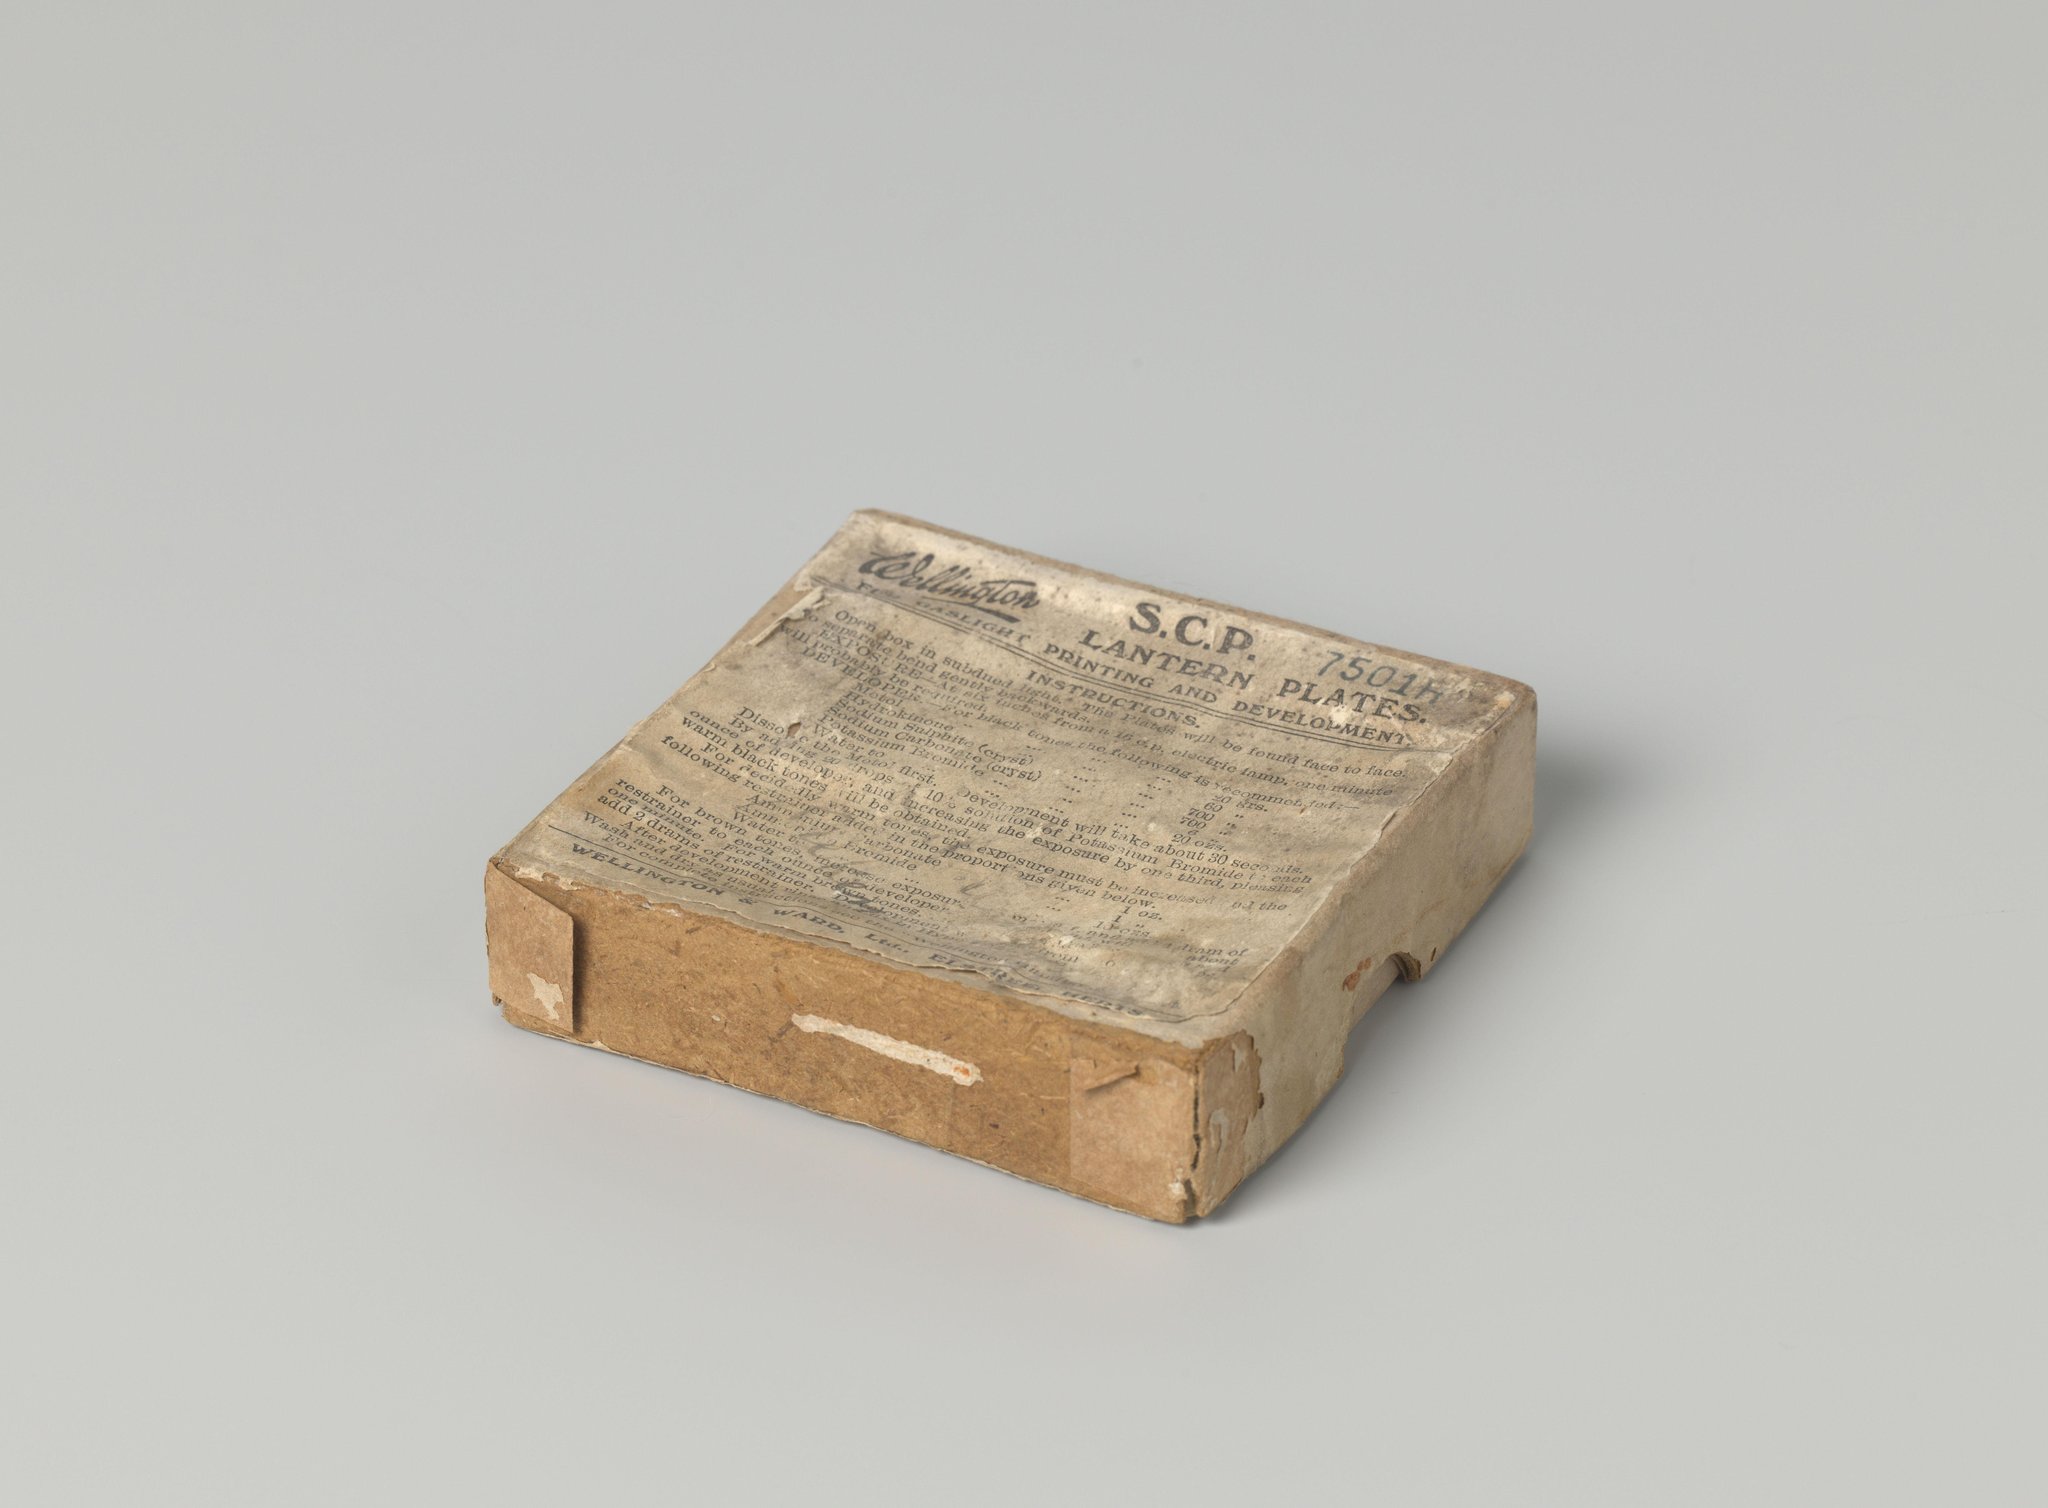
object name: box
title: Doos voor glasplaten van Wellington & Ward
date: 1890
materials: cardboard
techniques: printing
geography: elstree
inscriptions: number: ‘7501H’